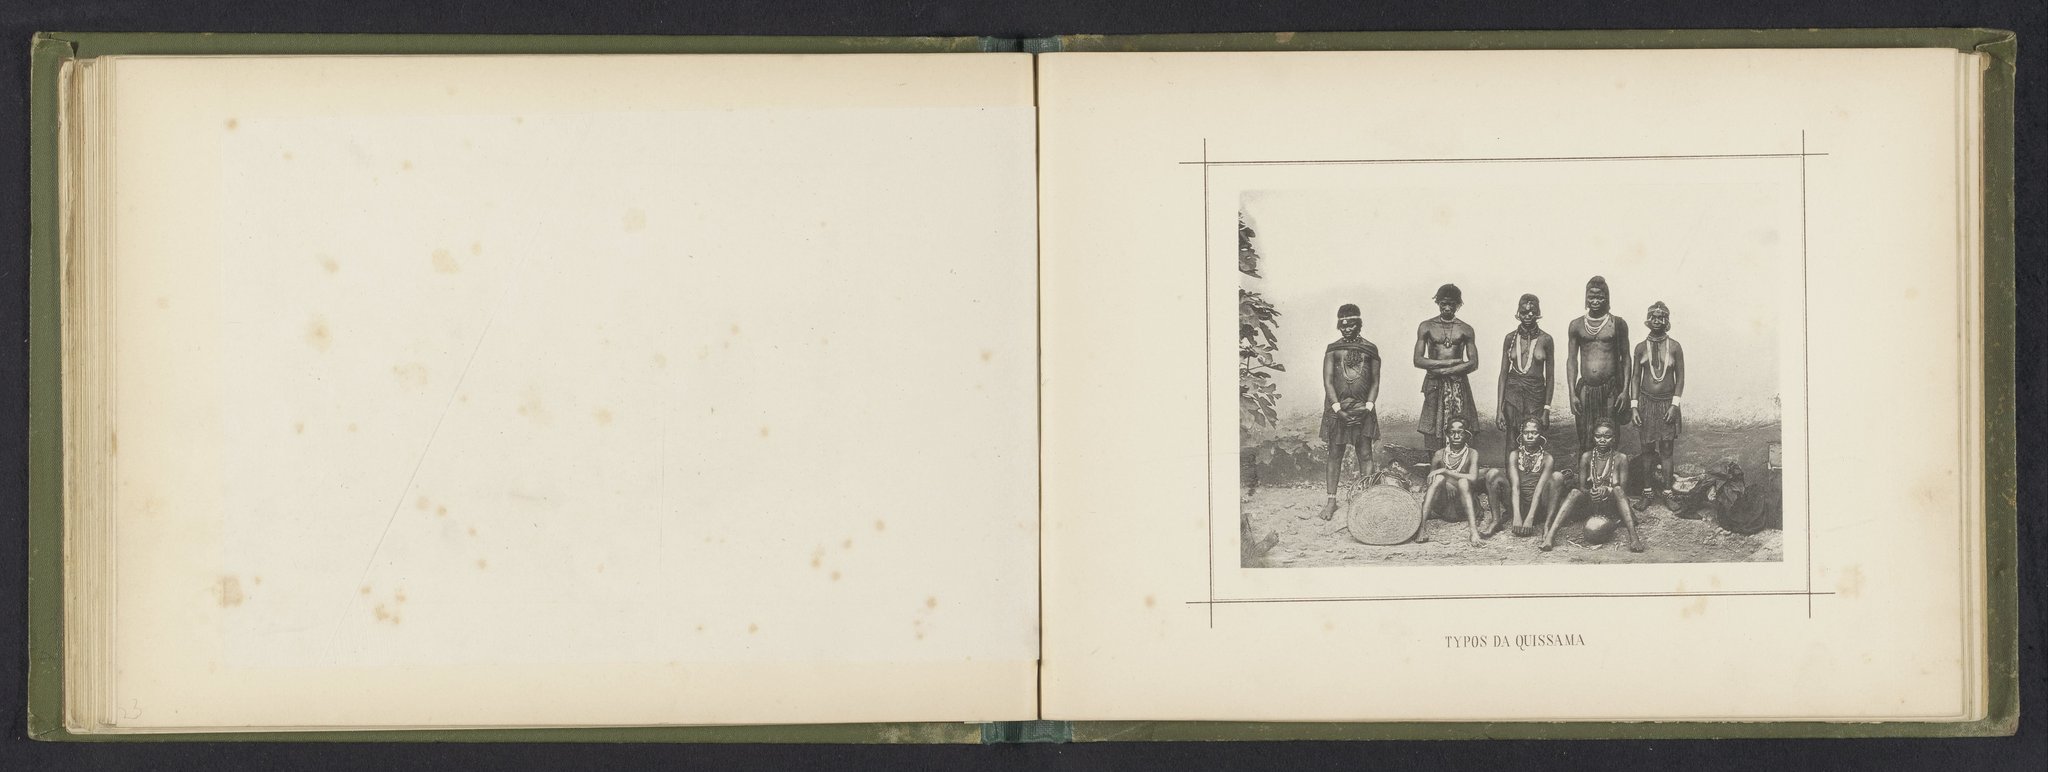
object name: photomechanical print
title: Groepsportret van acht inwoners van Quiçama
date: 1876-1886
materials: paper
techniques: photograph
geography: quiçama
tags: bracelet, wristlet, anonymous historical persons portrayed in a group, in a group-portrait